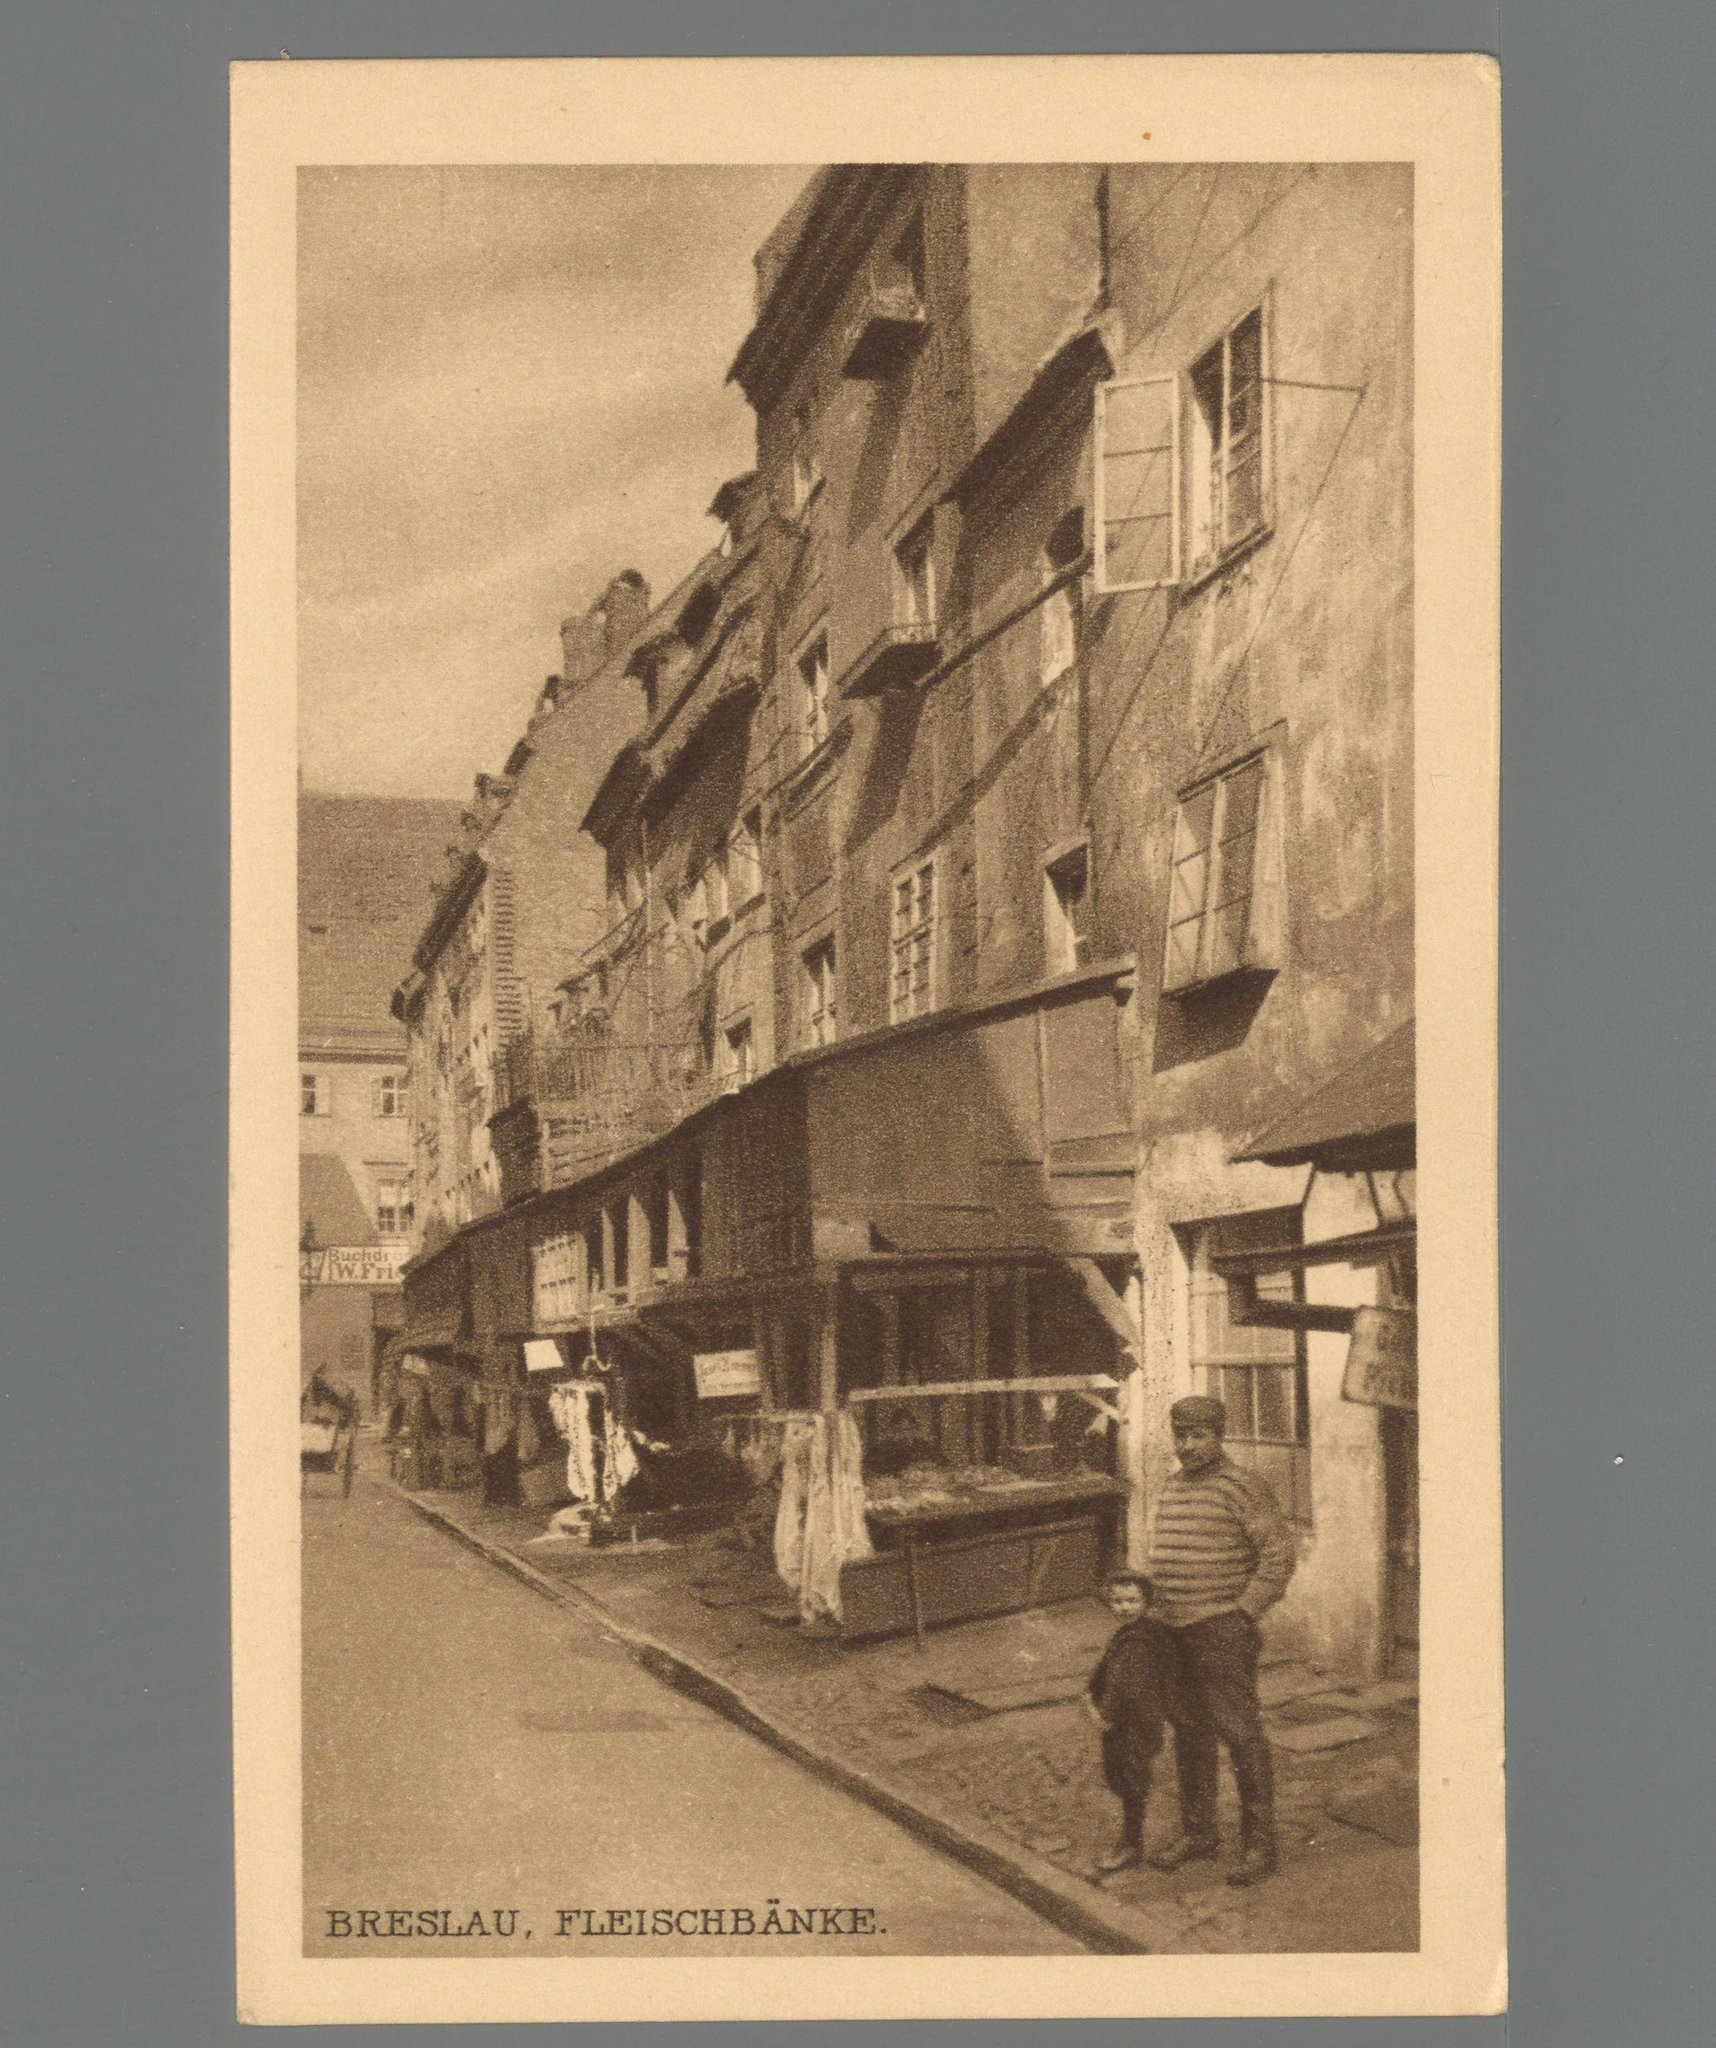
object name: photomechanical print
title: Breslau, Fleischbänke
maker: Anonymous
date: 1905-1930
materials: cardboard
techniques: rotogravure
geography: berlin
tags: shop, store, street